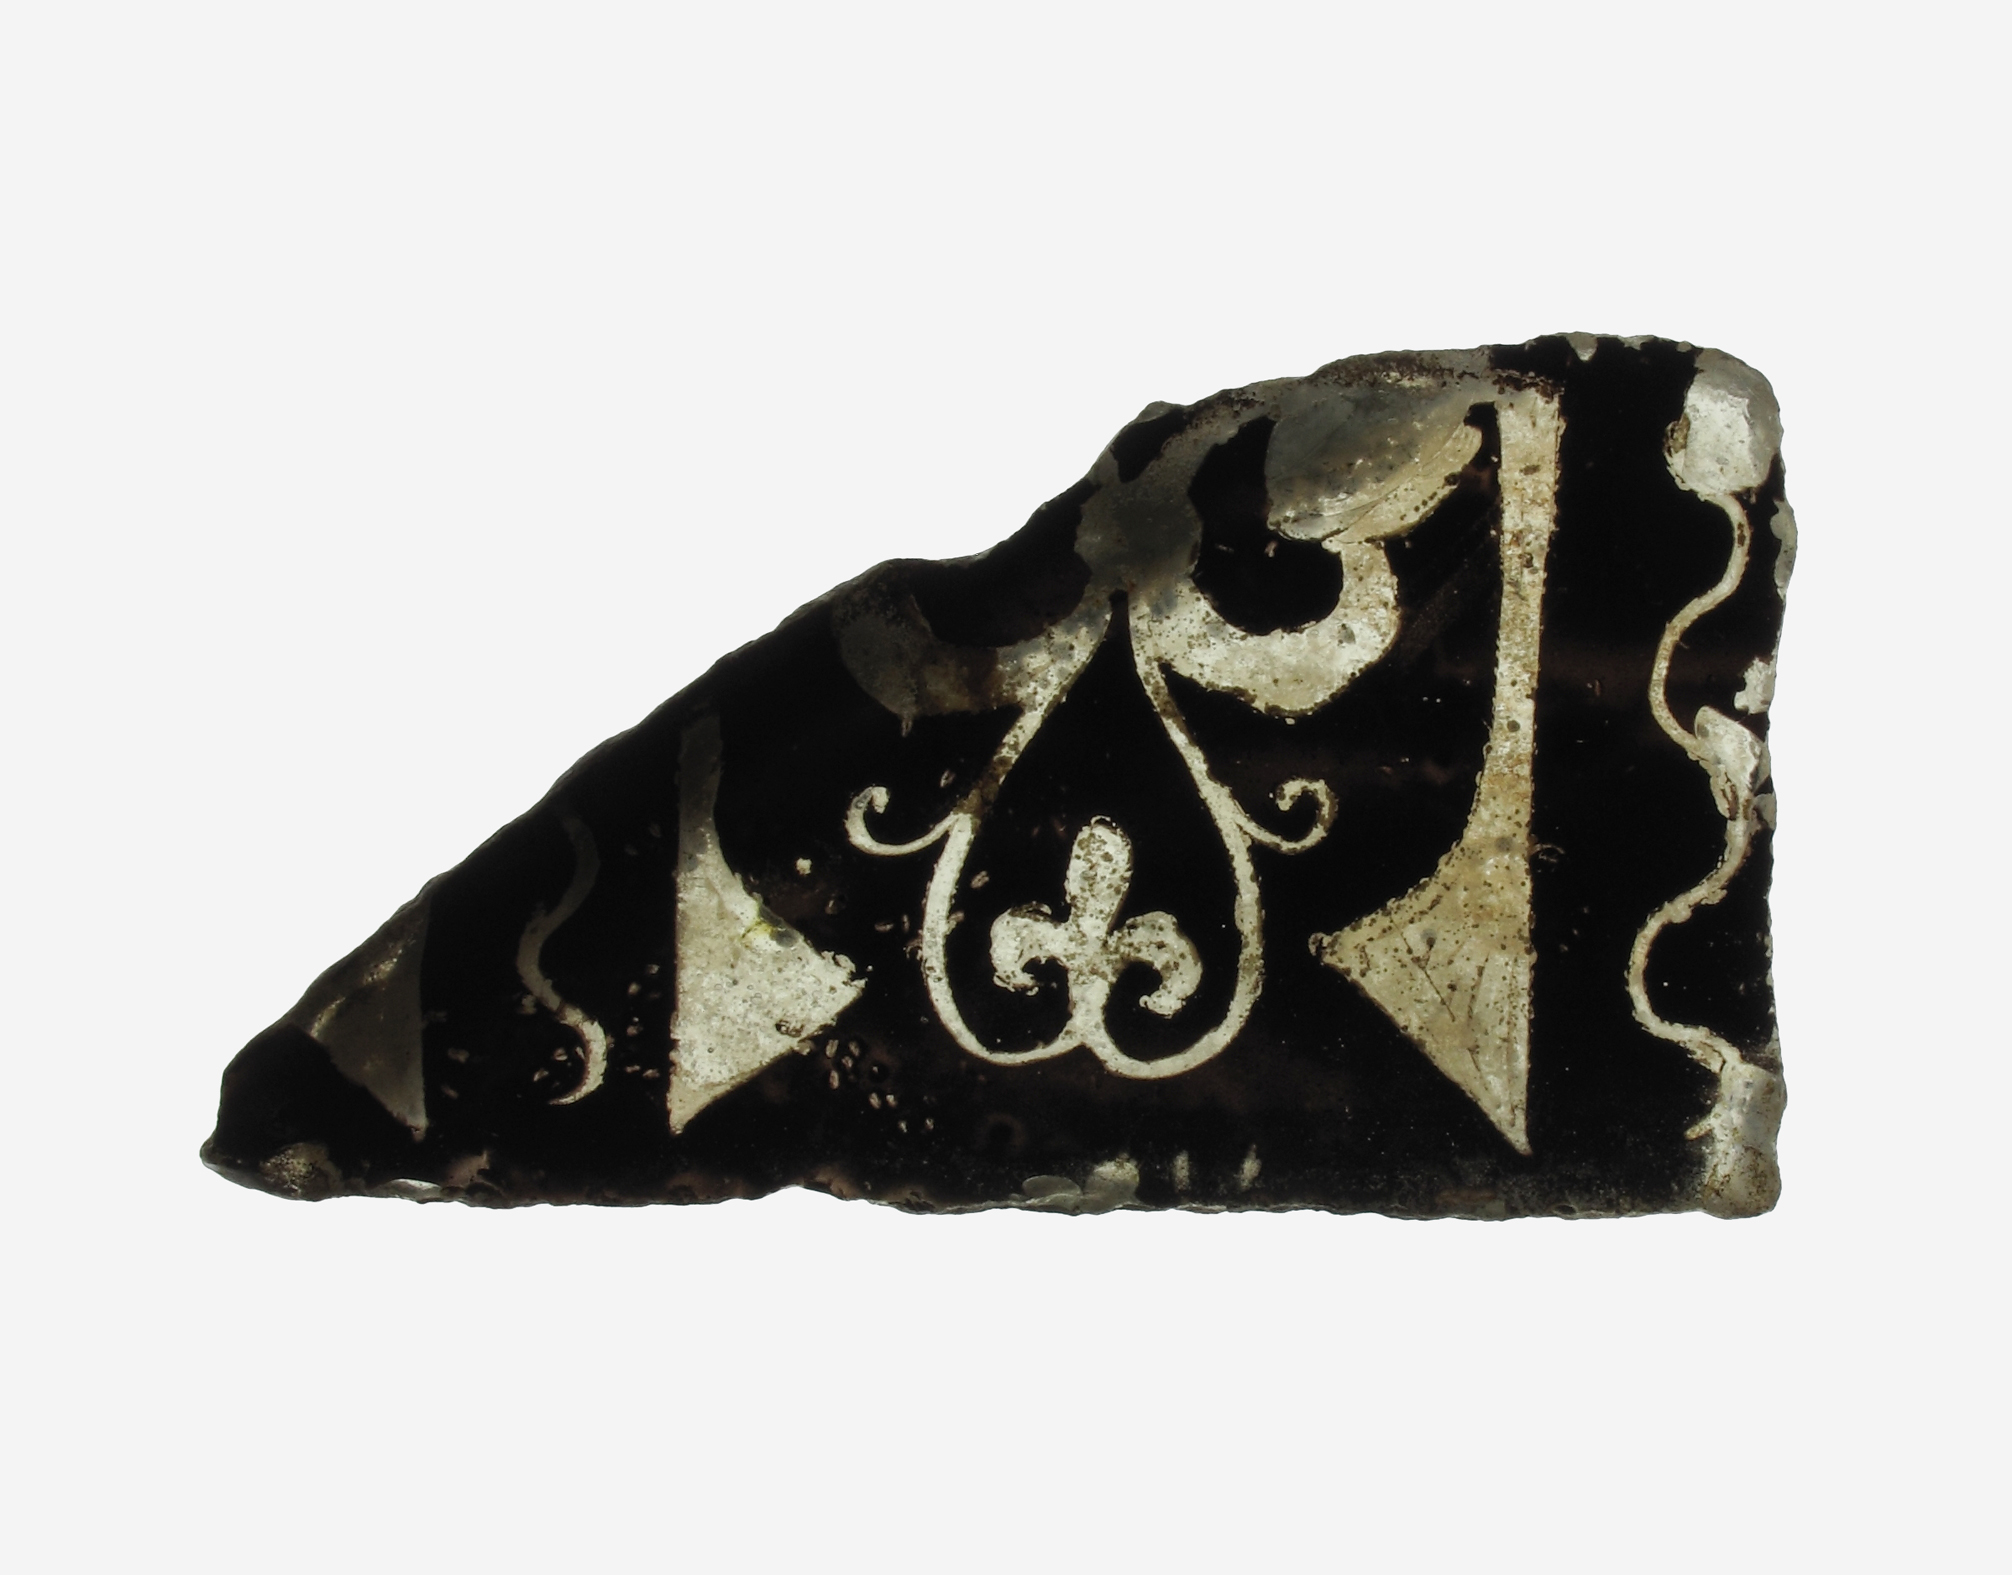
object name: fragment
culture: european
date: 1401-1500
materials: glass, metal, paint